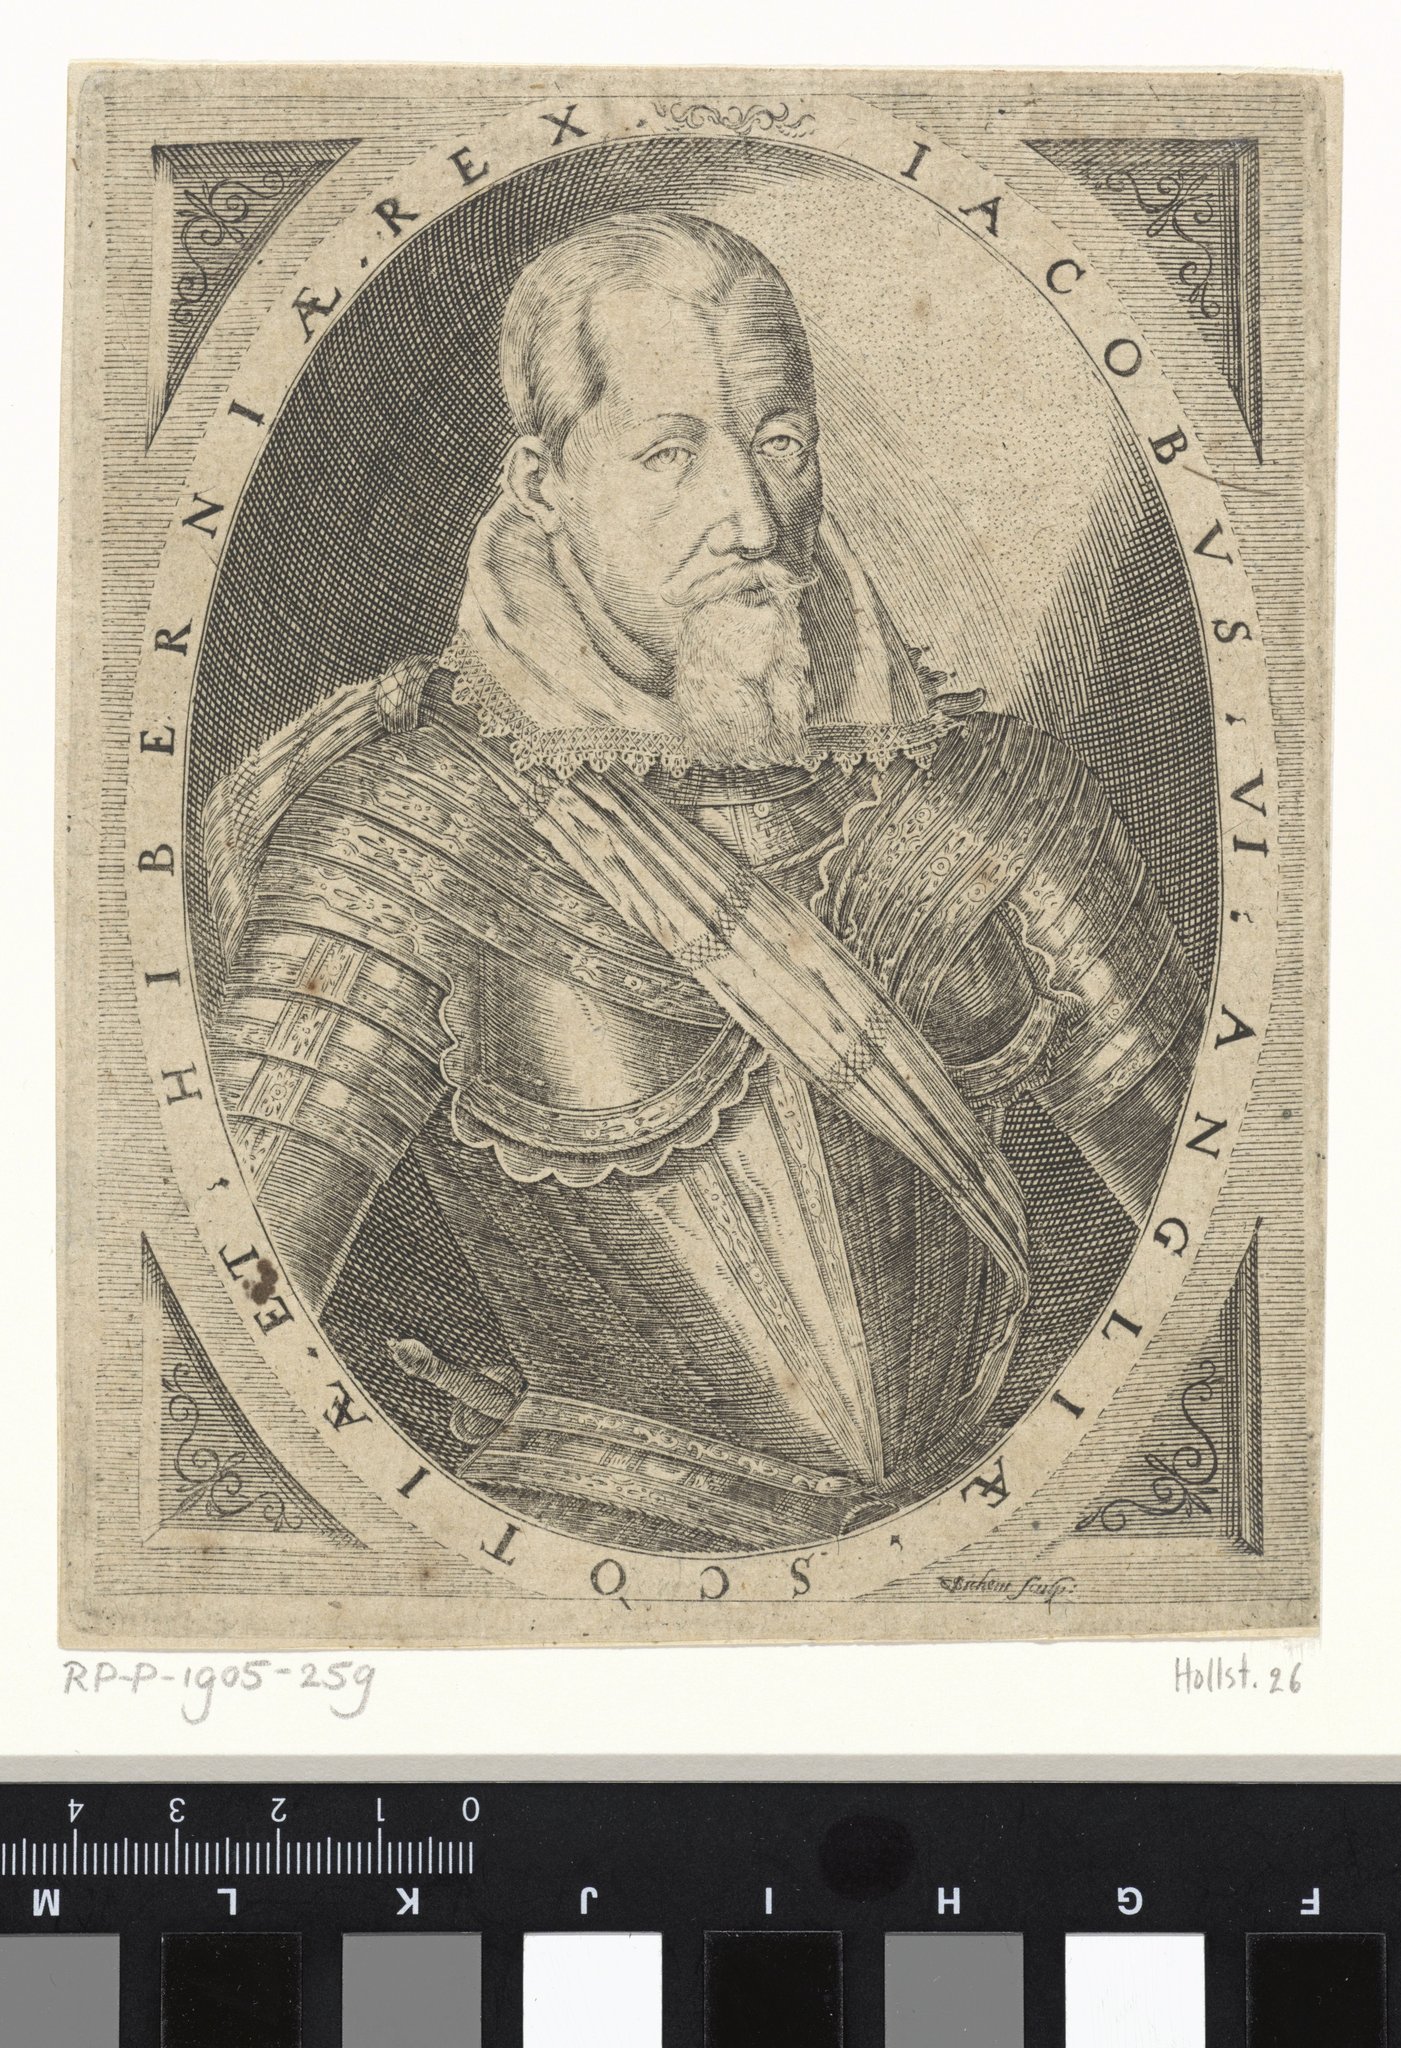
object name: print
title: Portret van Jacobus I, koning van Engeland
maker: christoffel van sichem (i)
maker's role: print maker, publisher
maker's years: 1546-1624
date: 1603-1614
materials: paper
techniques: engraving, etching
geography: amsterdam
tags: jacobus i (koning van engeland)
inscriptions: collector's mark: Lugt 2228, collector's mark: Lugt 1337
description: Portret van Jacobus I, koning van Engeland, hier geportretteerd als koning Jacobus VI van Schotland en Engeland. Hij draagt een harnas met sjerp en een kanten kraag. In het ovaal rondom het portret zijn naam en titel.